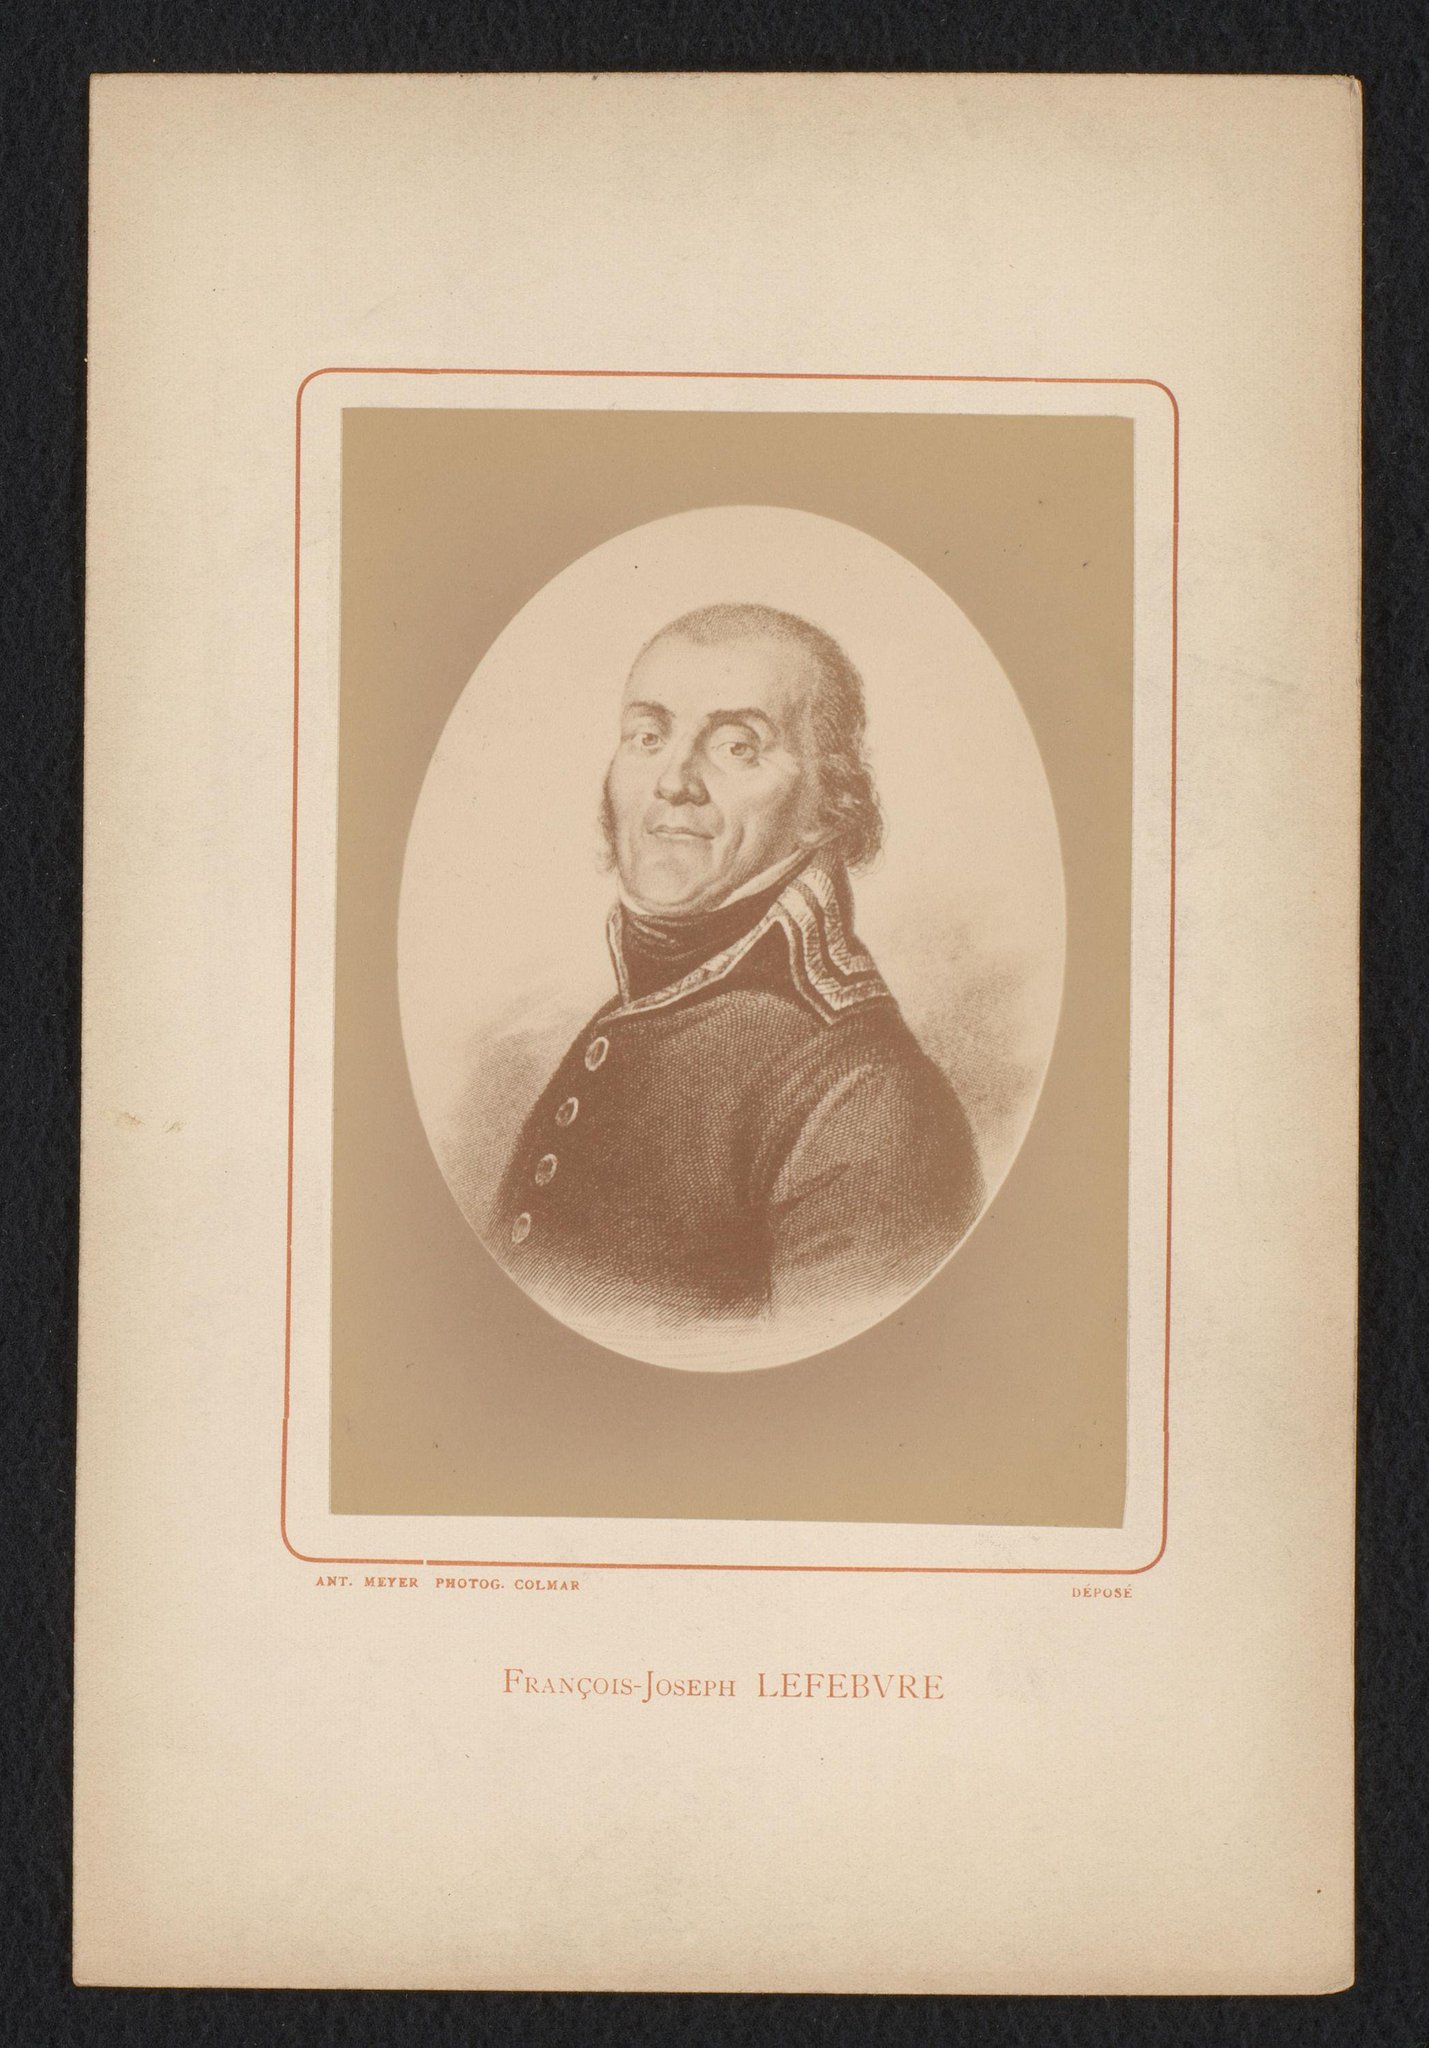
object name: photograph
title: François-Joseph Lefebvre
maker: anton meyer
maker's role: fotograaf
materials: photographic support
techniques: albumen print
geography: colmar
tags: ranks in the army, historical persons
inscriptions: inscription: ‘Déposé’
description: Deze foto maakt deel uit van een omslag met 29 foto's op 29 bladen en 23 teksbladen.